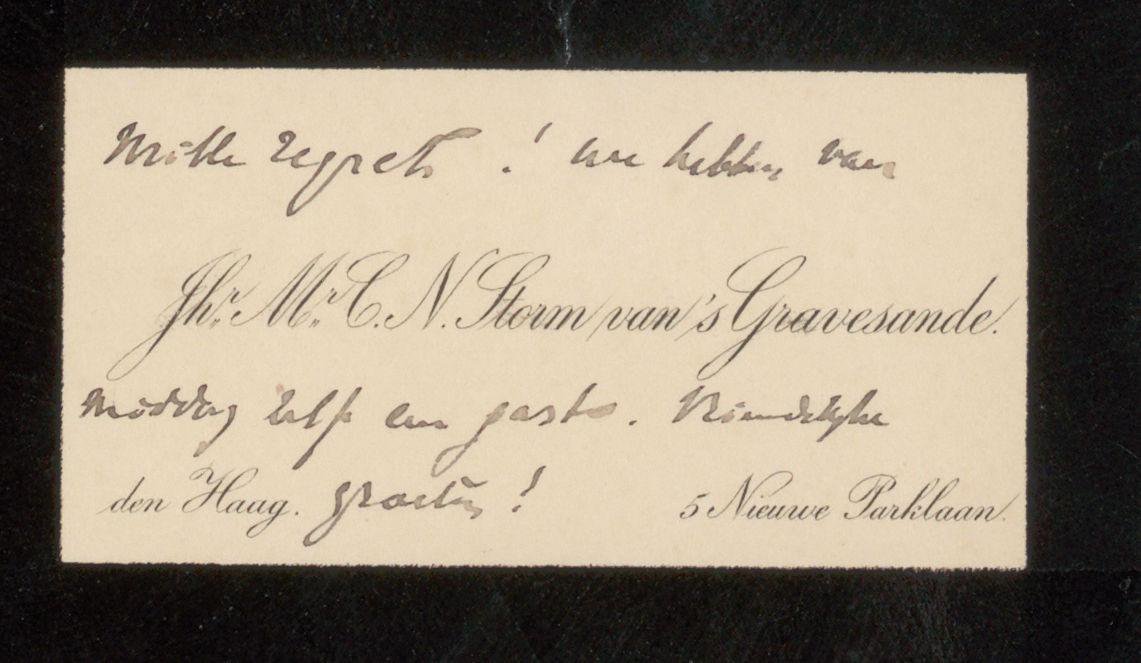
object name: visiting card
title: Visitekaartje aan Philip Zilcken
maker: carel nicolaas storm van s-gravesande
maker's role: draughtsman, print maker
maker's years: 1841-1924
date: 1851-1924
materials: cardboard, ink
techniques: pen, printing, writing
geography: the hague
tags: painter, philip zilcken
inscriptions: collector's mark: ‘RPK’